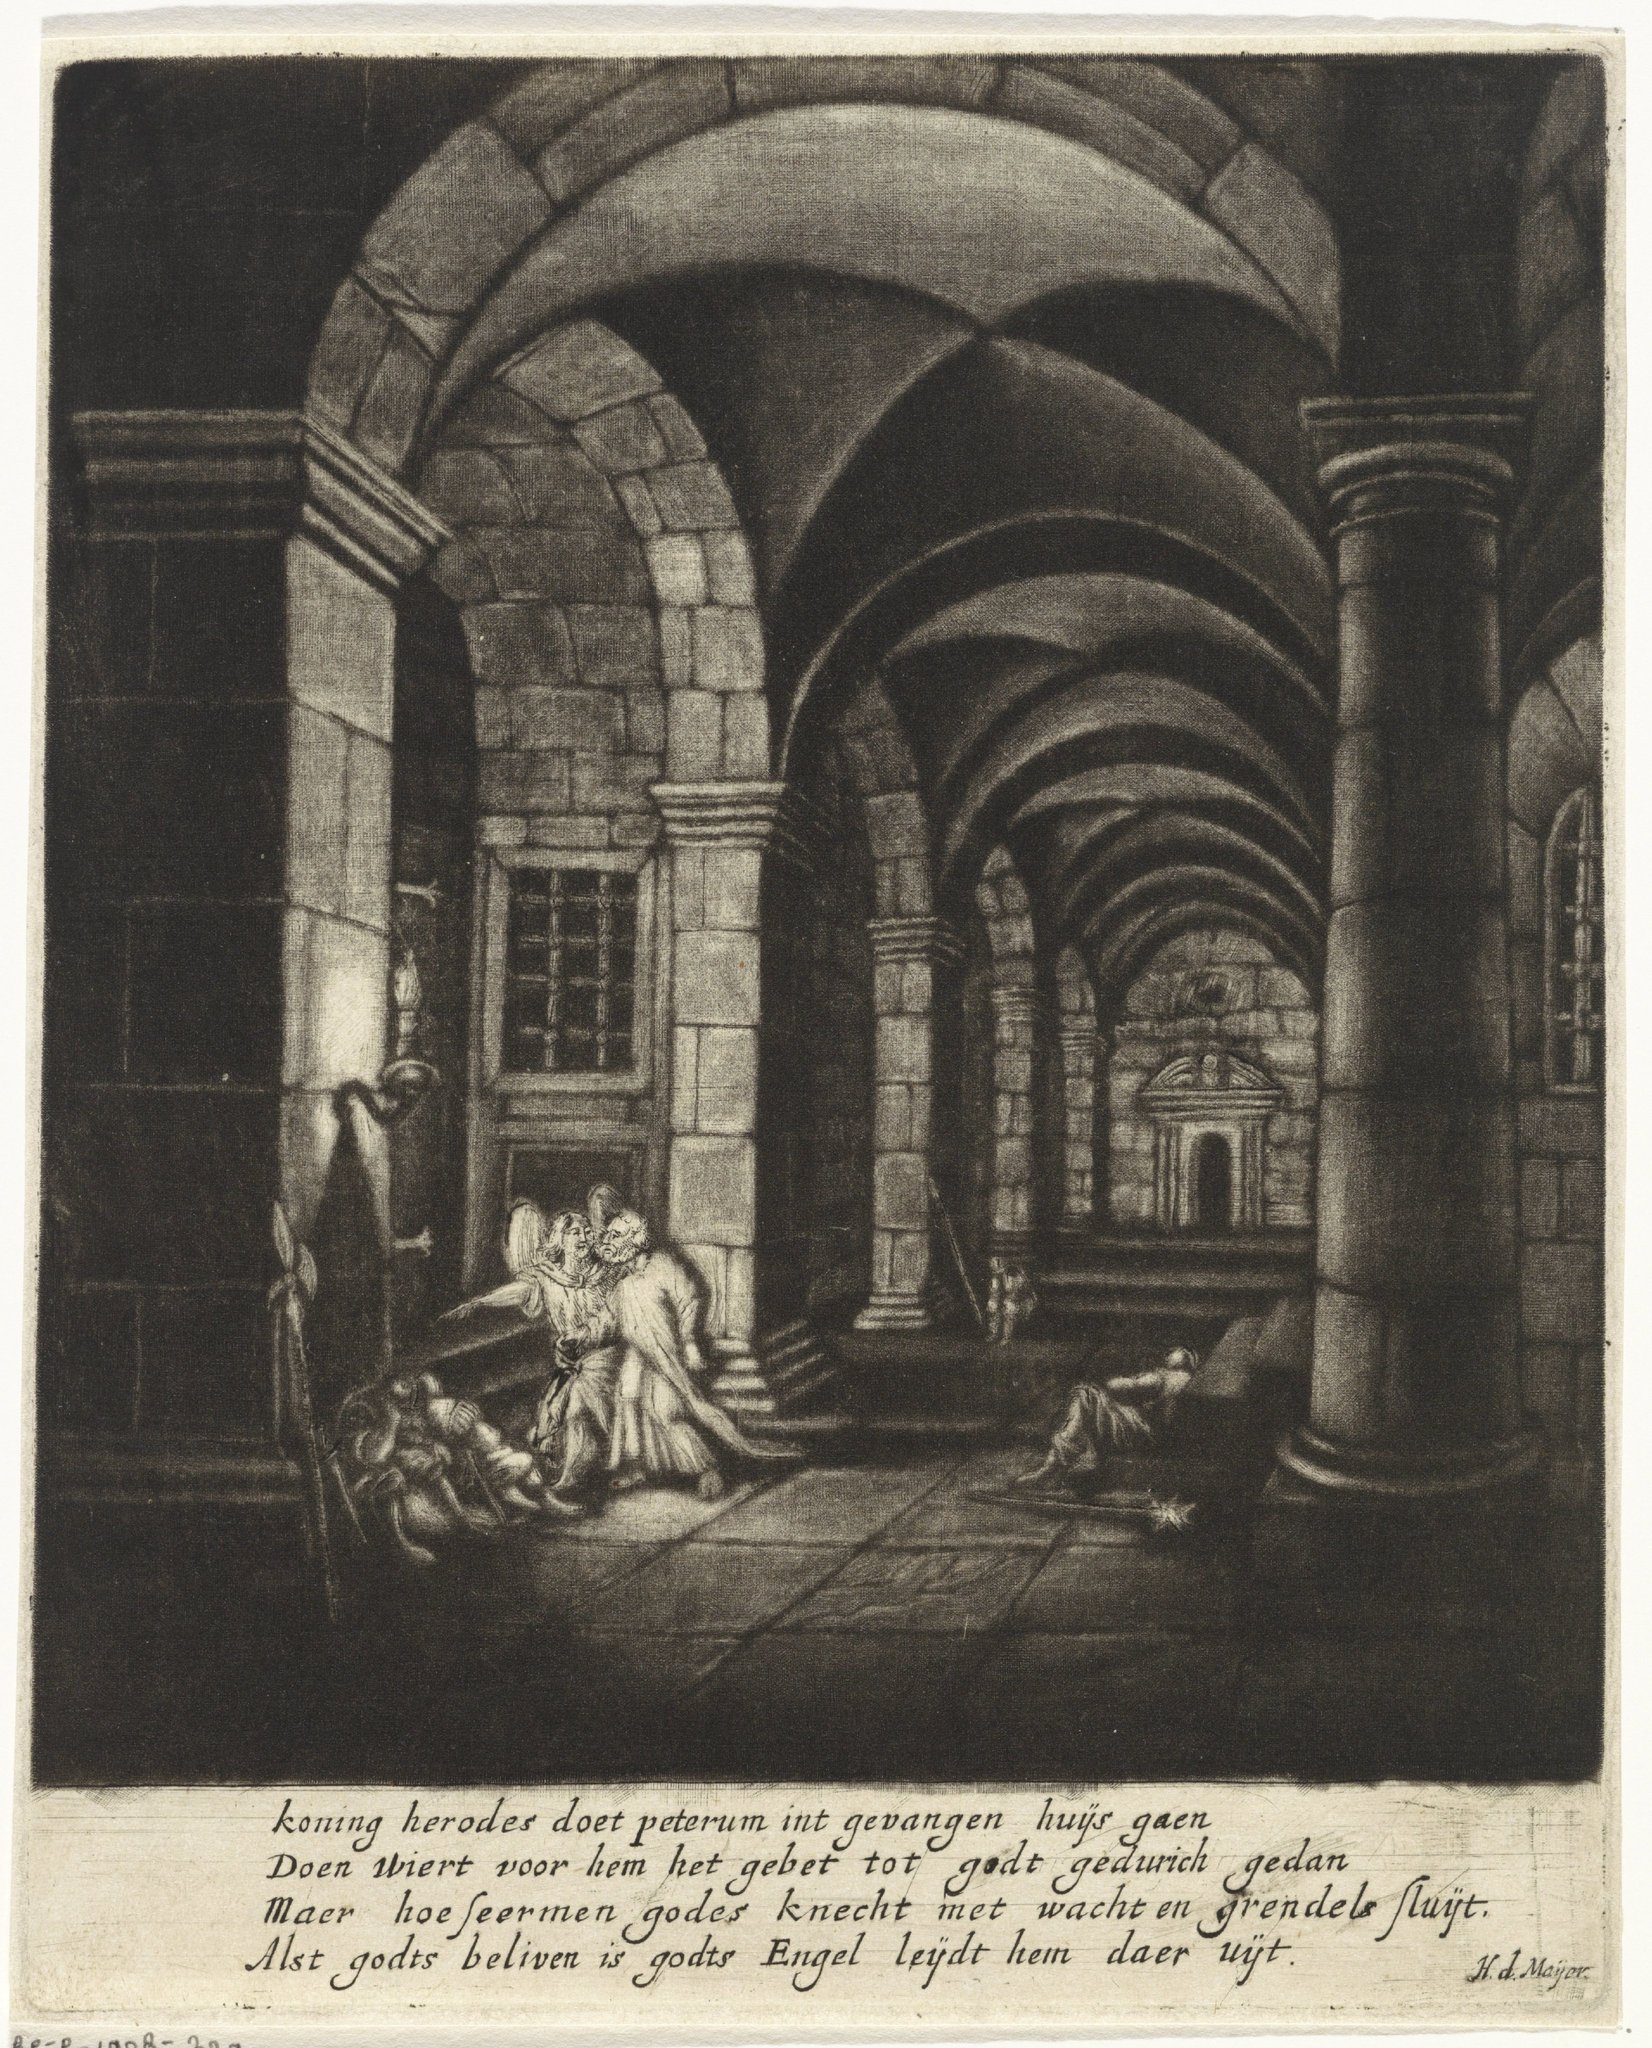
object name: print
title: Bevrijding van Petrus uit de gevangenis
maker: harmen de mayer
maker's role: print maker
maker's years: 1624-1701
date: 1651-1701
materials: paper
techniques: engraving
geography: amsterdam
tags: prison, jail, the angel leads peter past the sleeping guards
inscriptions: collector's mark: Lugt 2228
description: Een engel leidt Petrus langs de slapende wachten uit de gevangenis. Naar het bijbelverhaal in Hand. 12: 9-10.